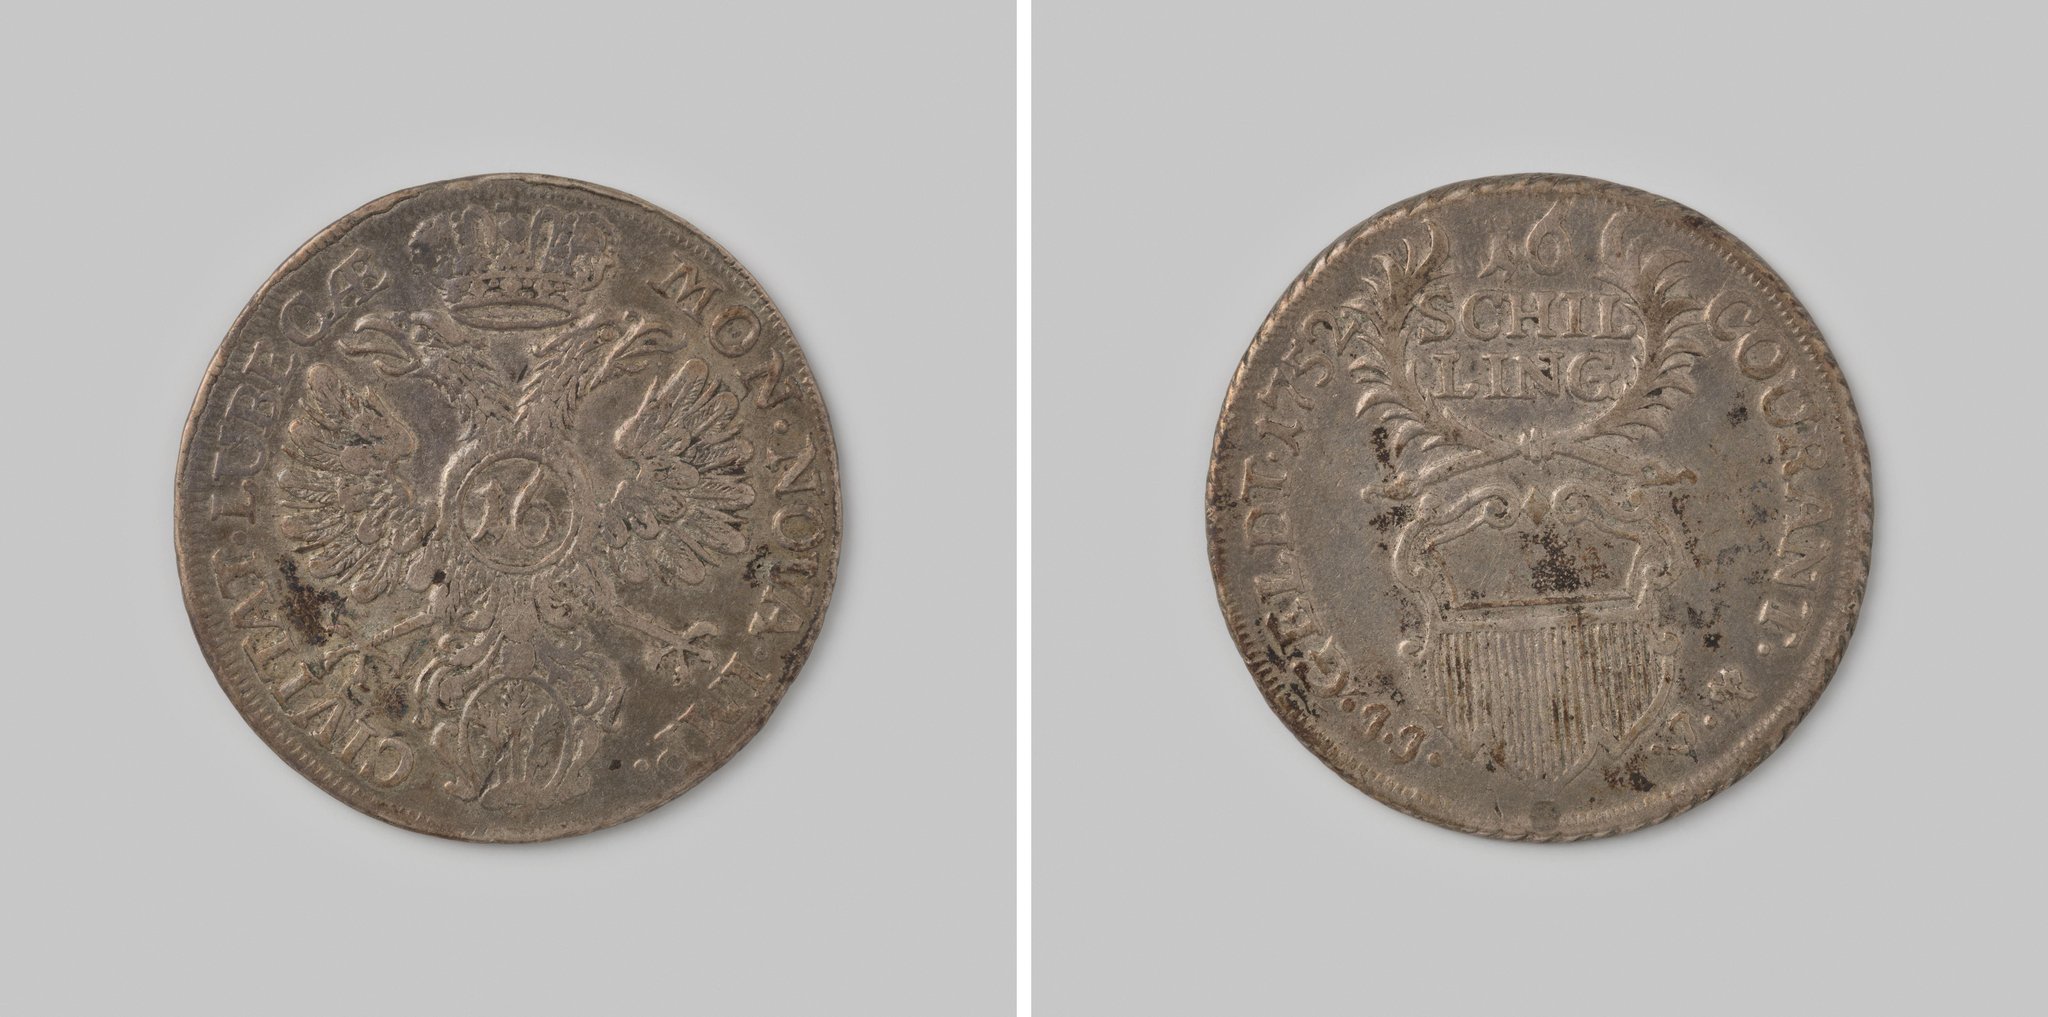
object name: coin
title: Vrije Hansestad Lübeck, 16 Schilling, 1752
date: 1752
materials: silver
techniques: striking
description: Zilveren munt. Voorzijde: gekroonde dubbelkoppige adelaar met op de borst het cijfer 16. Keerzijde: binnen twee samengebonden takken waarde-aanduiding in drie regels, waaronder wapenschild van de stad. Jaartal bovenaan aan eind van omschrift. Kabelrand.